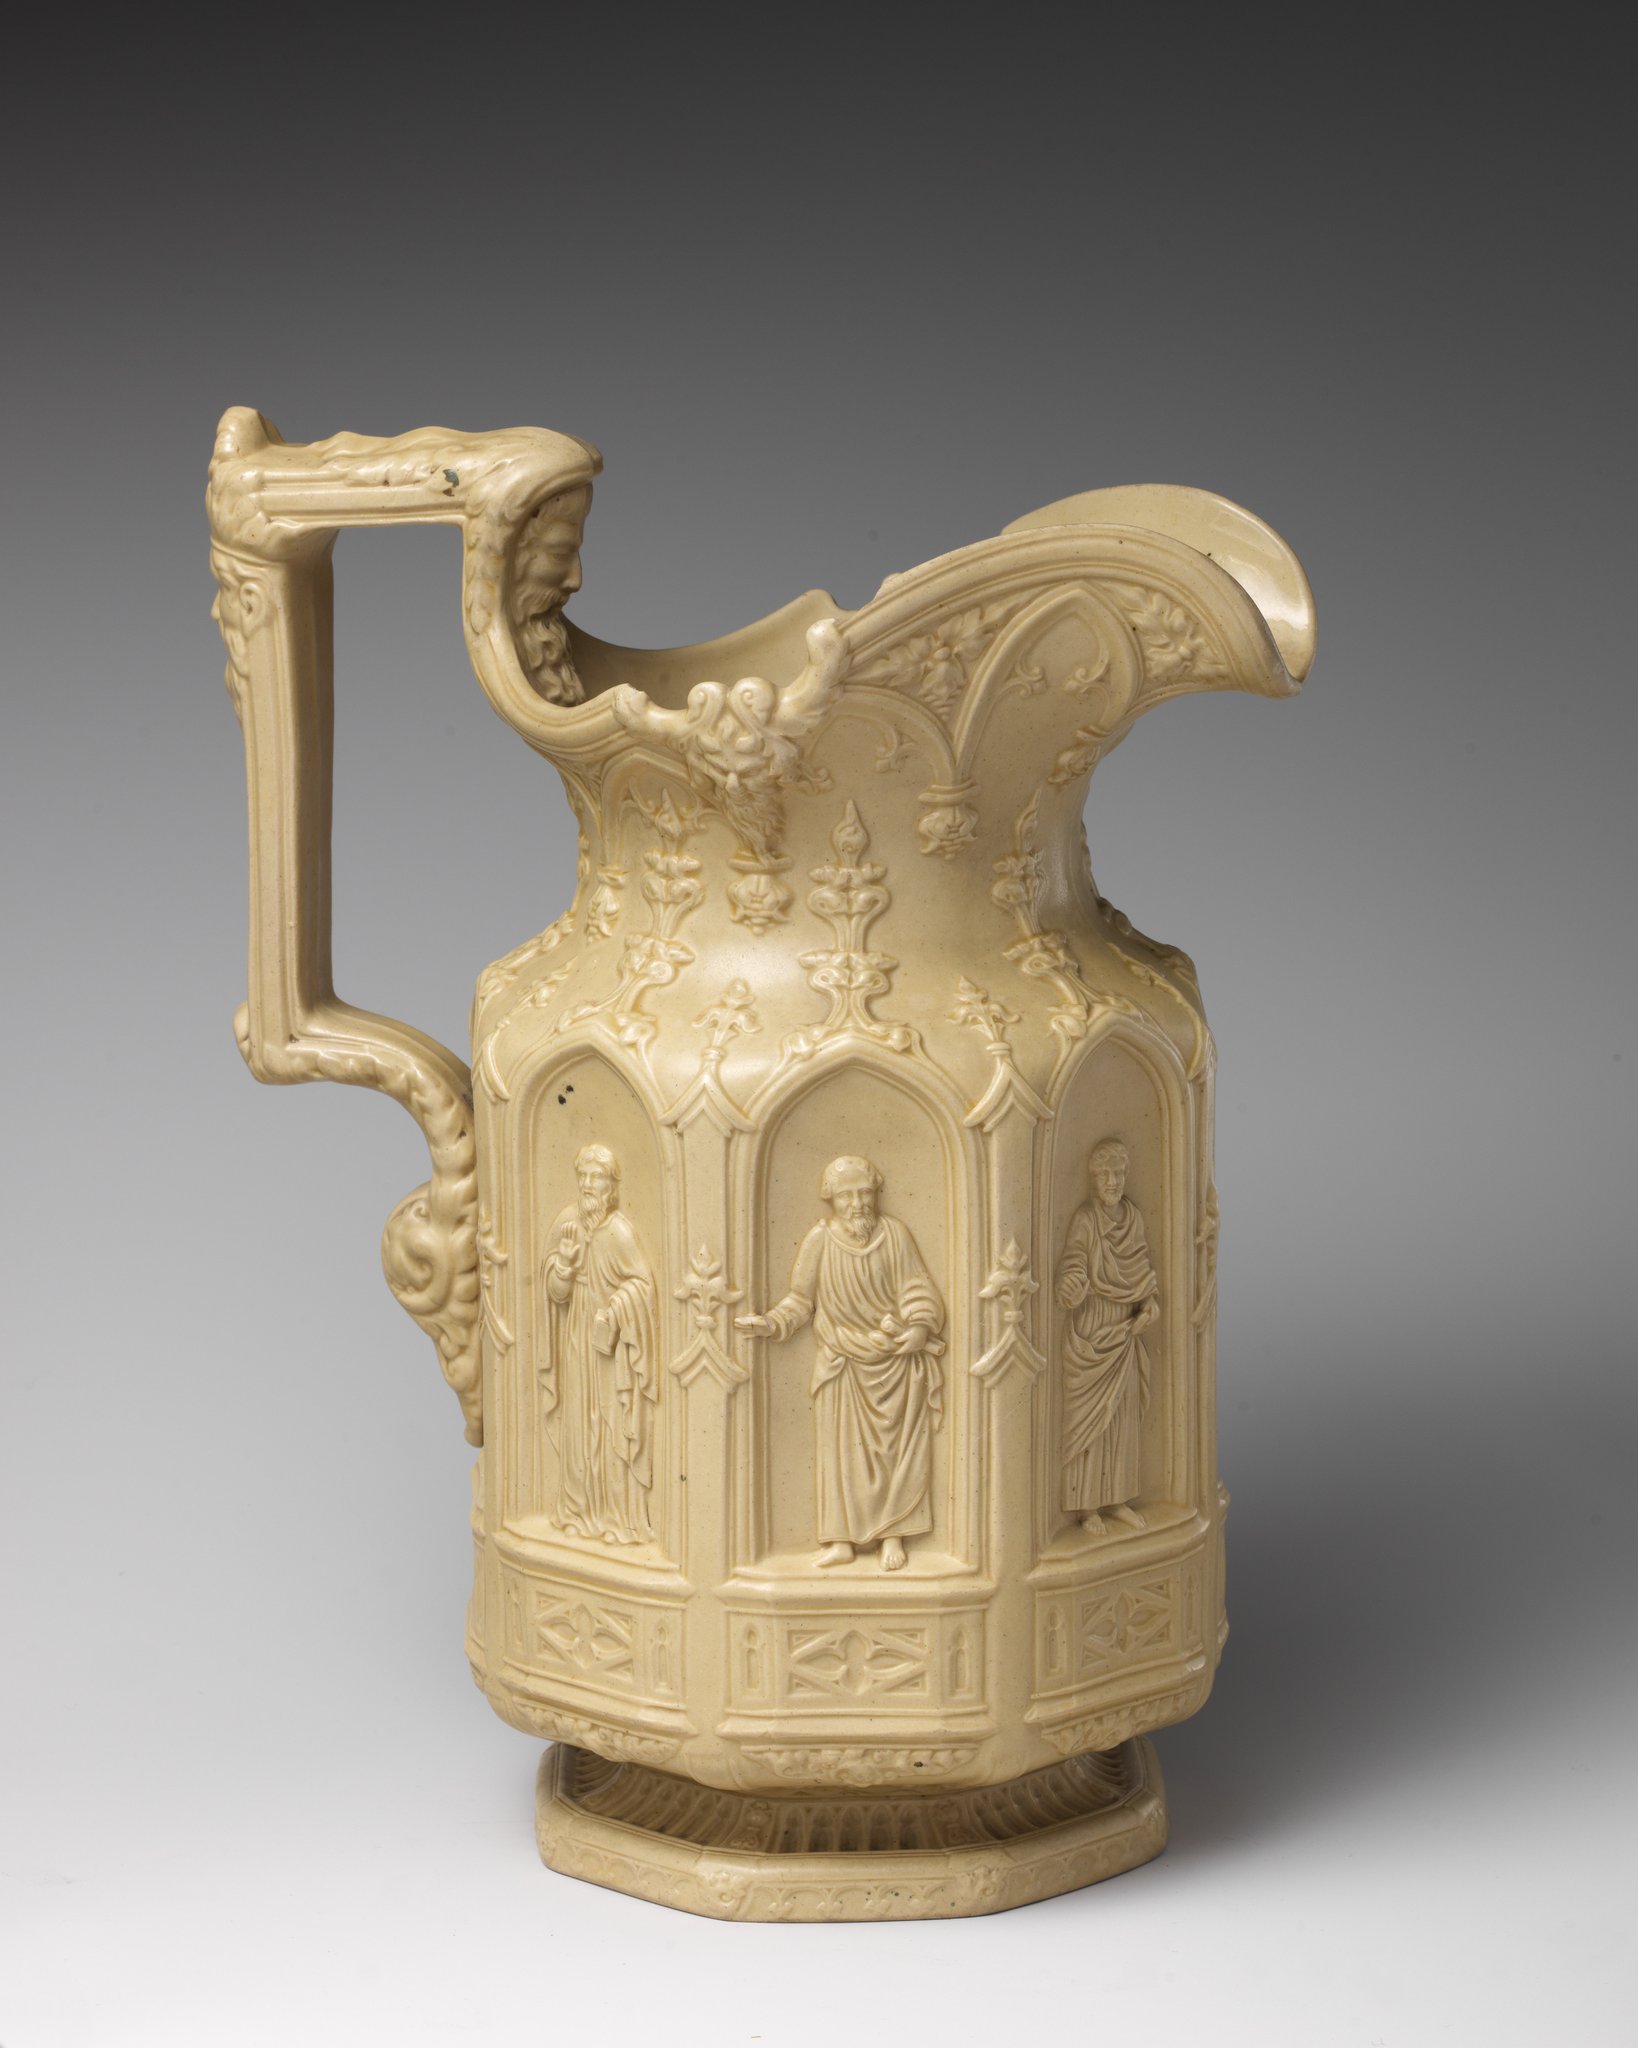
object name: jug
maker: charles meigh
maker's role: artist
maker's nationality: british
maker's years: 1835-1861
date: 1842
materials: stoneware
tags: faces,men,coat of arms